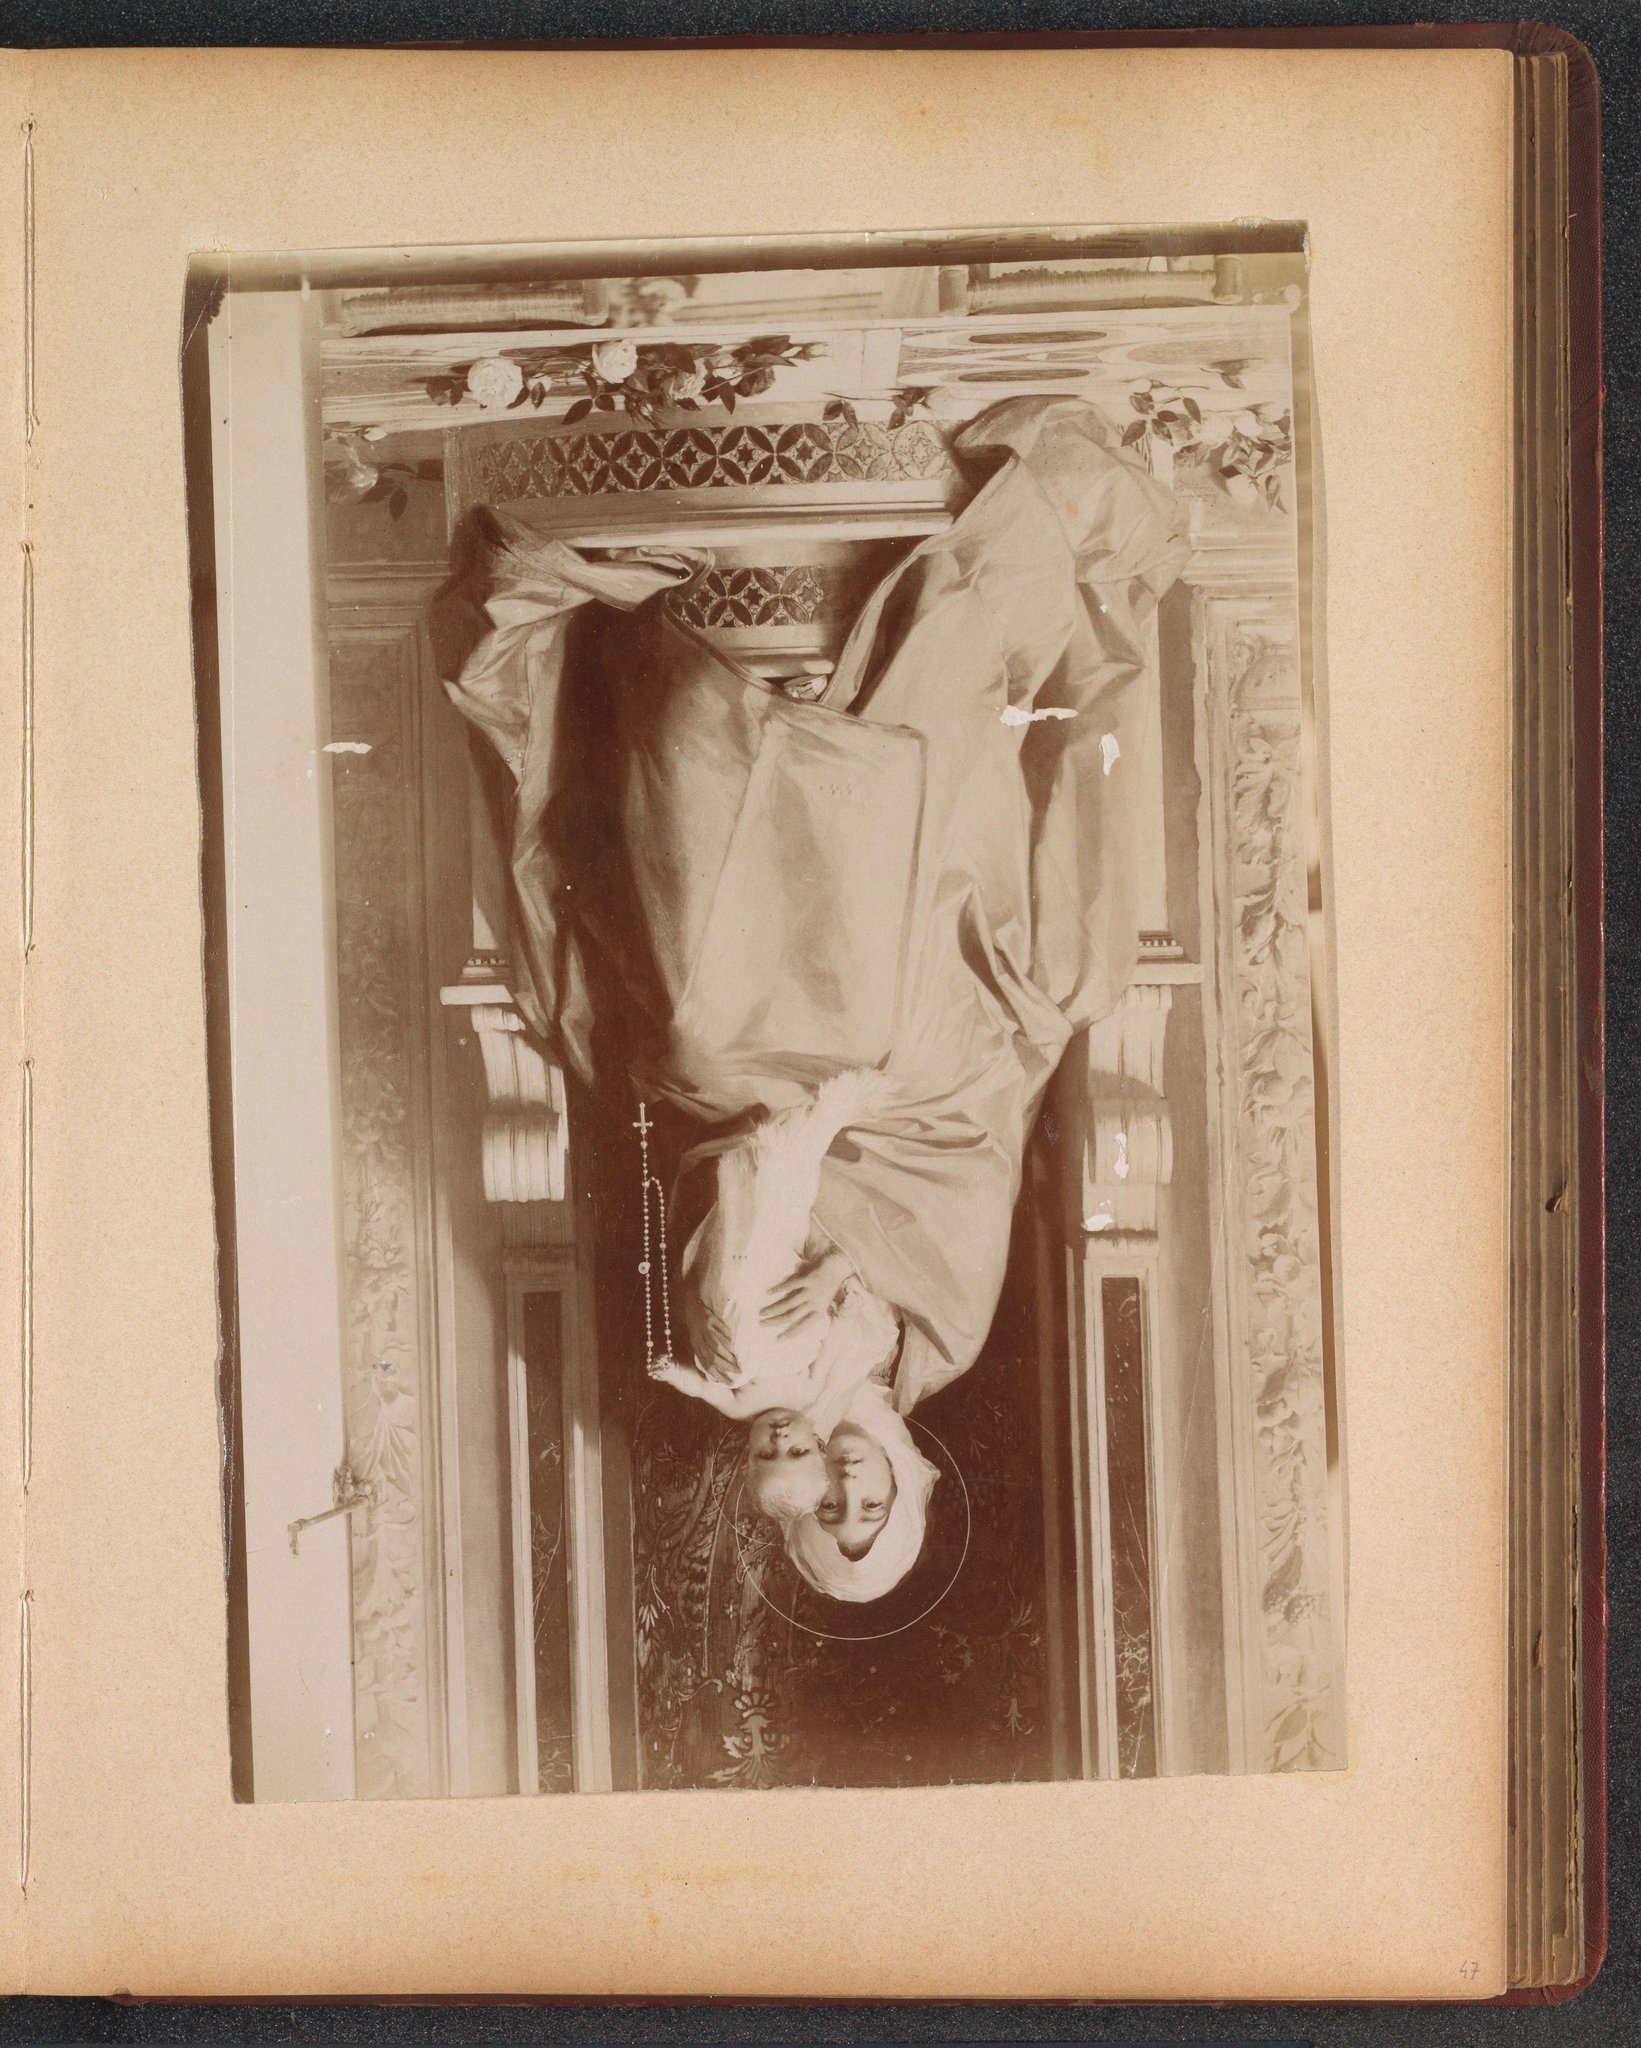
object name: reproduction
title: Fotoreproductie van (vermoedelijk) een schilderij in Genua, voorstellend Maria van de Rozenkrans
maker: Anonymous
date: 1870-1900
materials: paper, photographic support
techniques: albumen print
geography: genoa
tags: madonna: i.e. mary with the christ-child, madonna of the rosary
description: Onderdeel van Reisalbum met foto's van bezienswaardigheden in Italië en Zuid-Frankrijk.